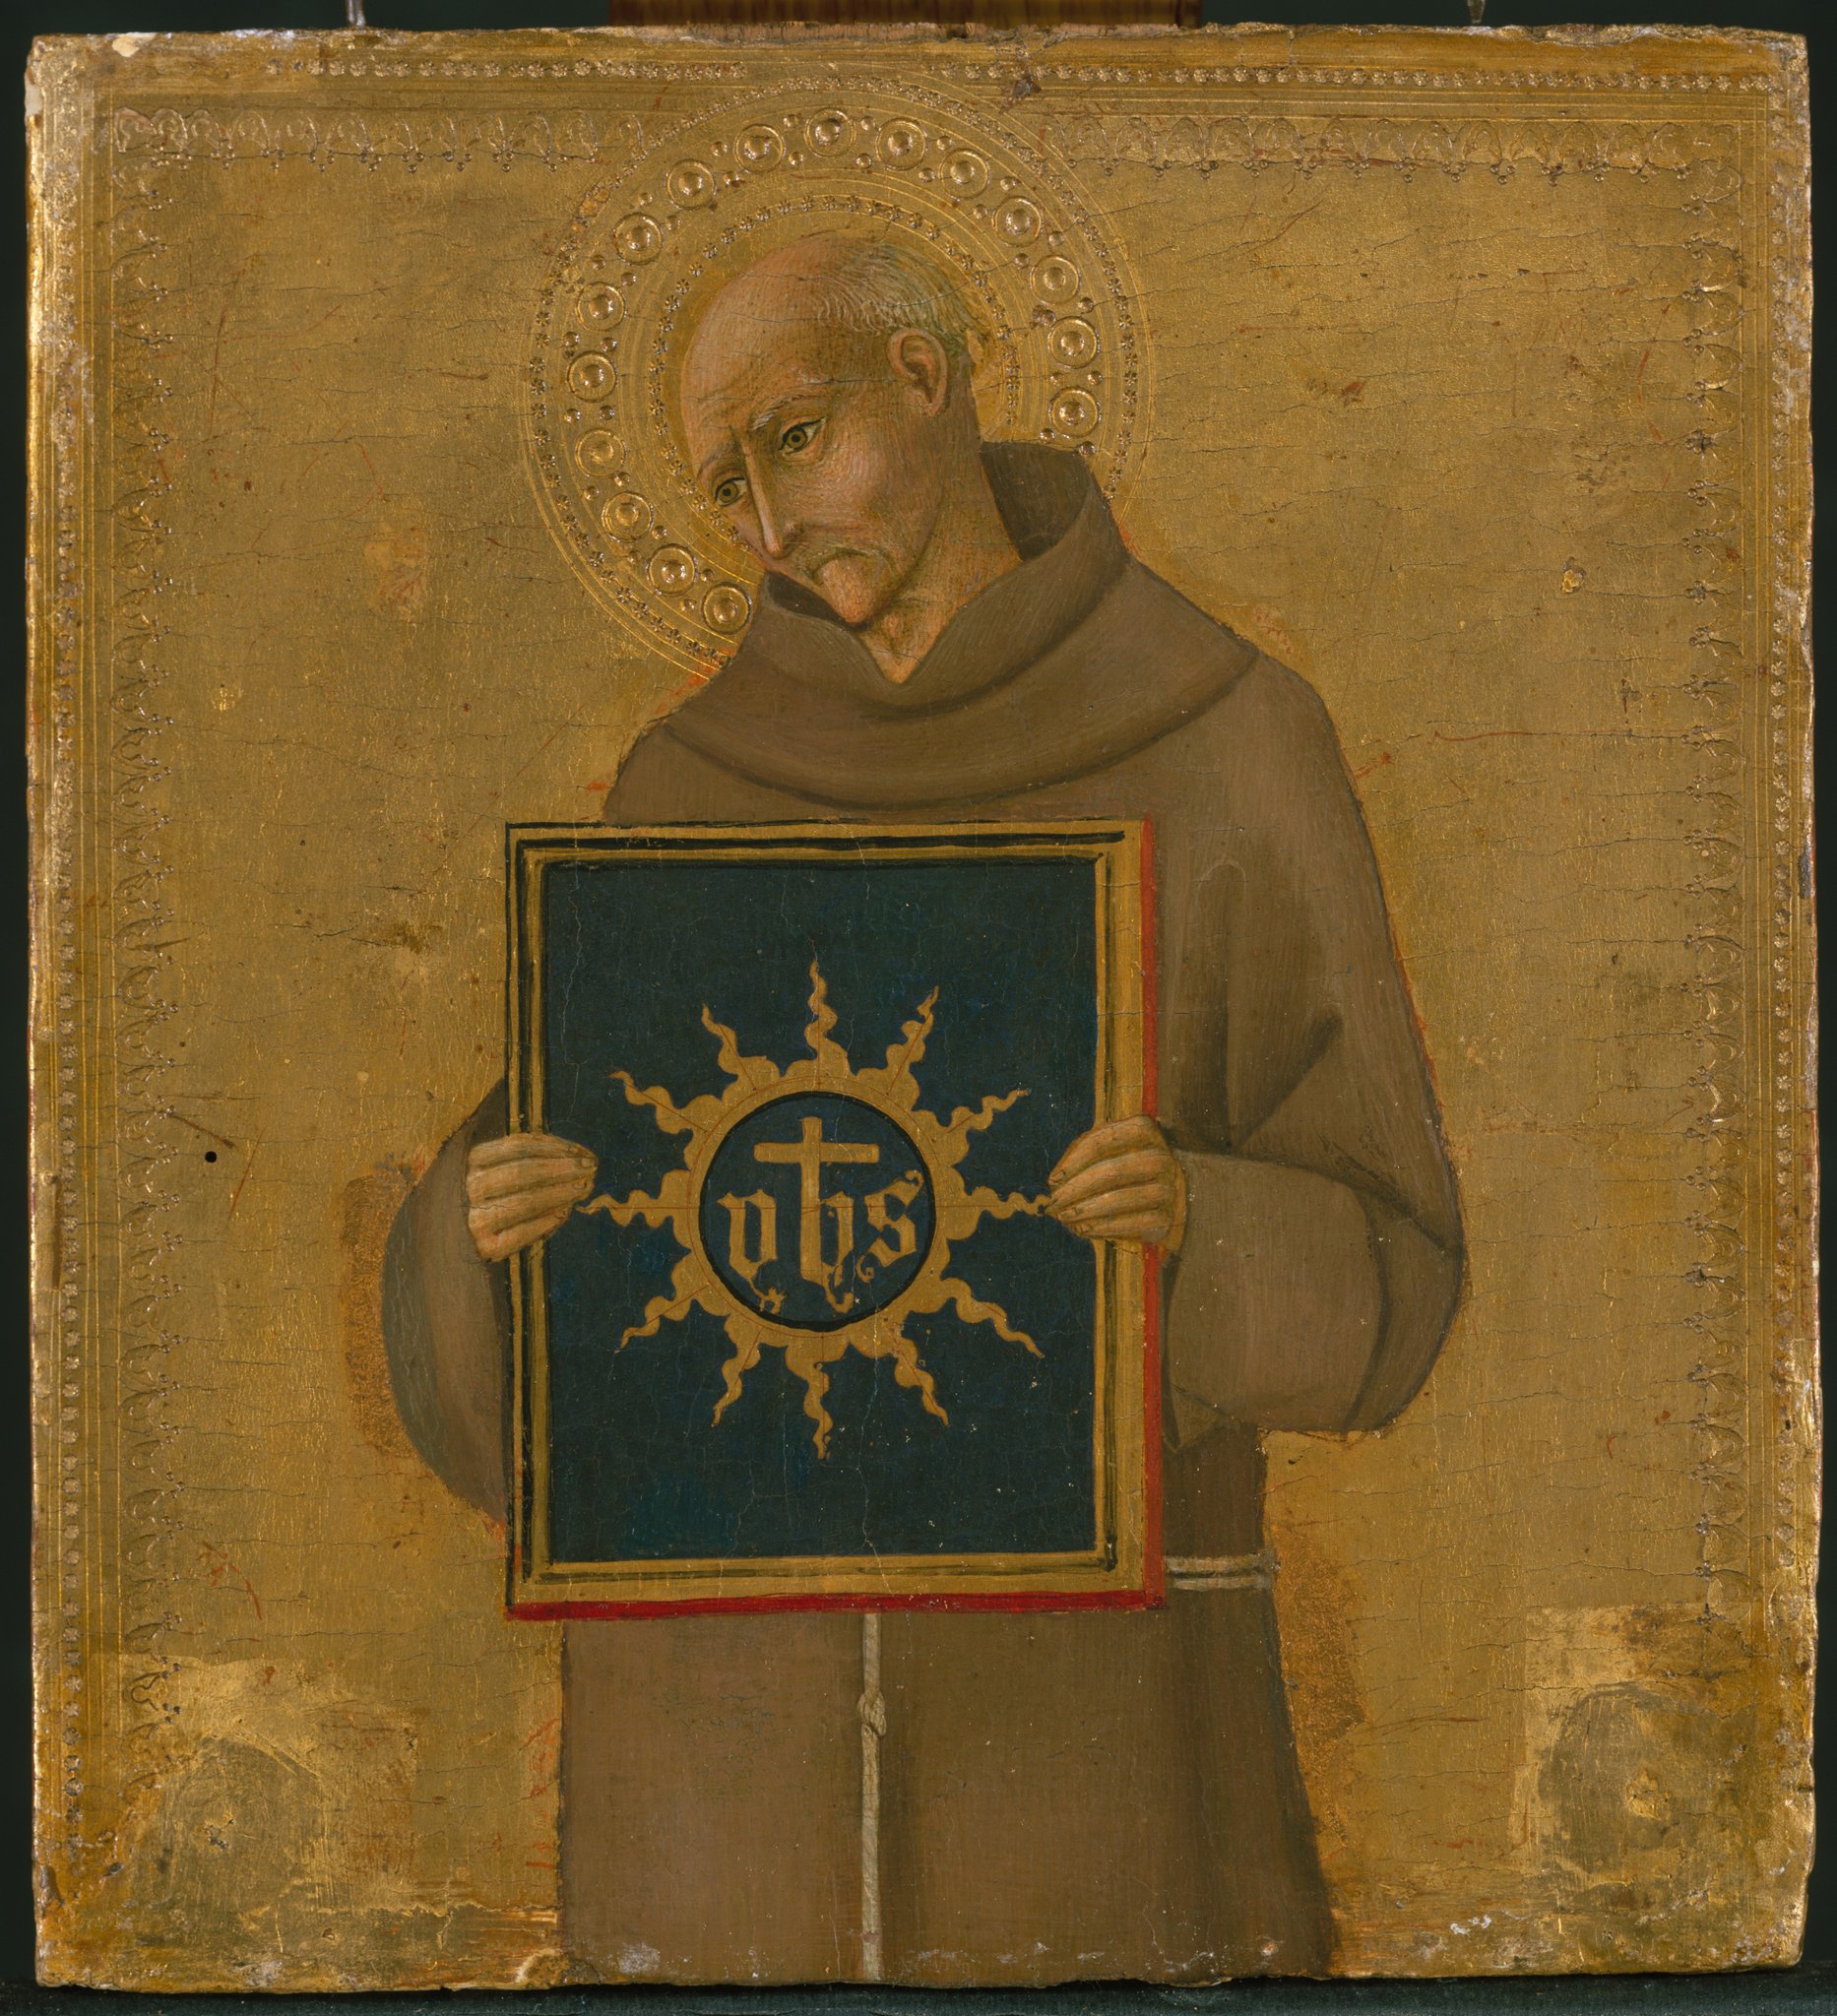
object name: painting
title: Saint Bernardino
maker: sano di pietro (ansano di pietro di mencio)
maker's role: artist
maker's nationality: italian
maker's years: 1405-1481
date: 1450-1460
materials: gold leaf, paint, wood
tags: men,saints